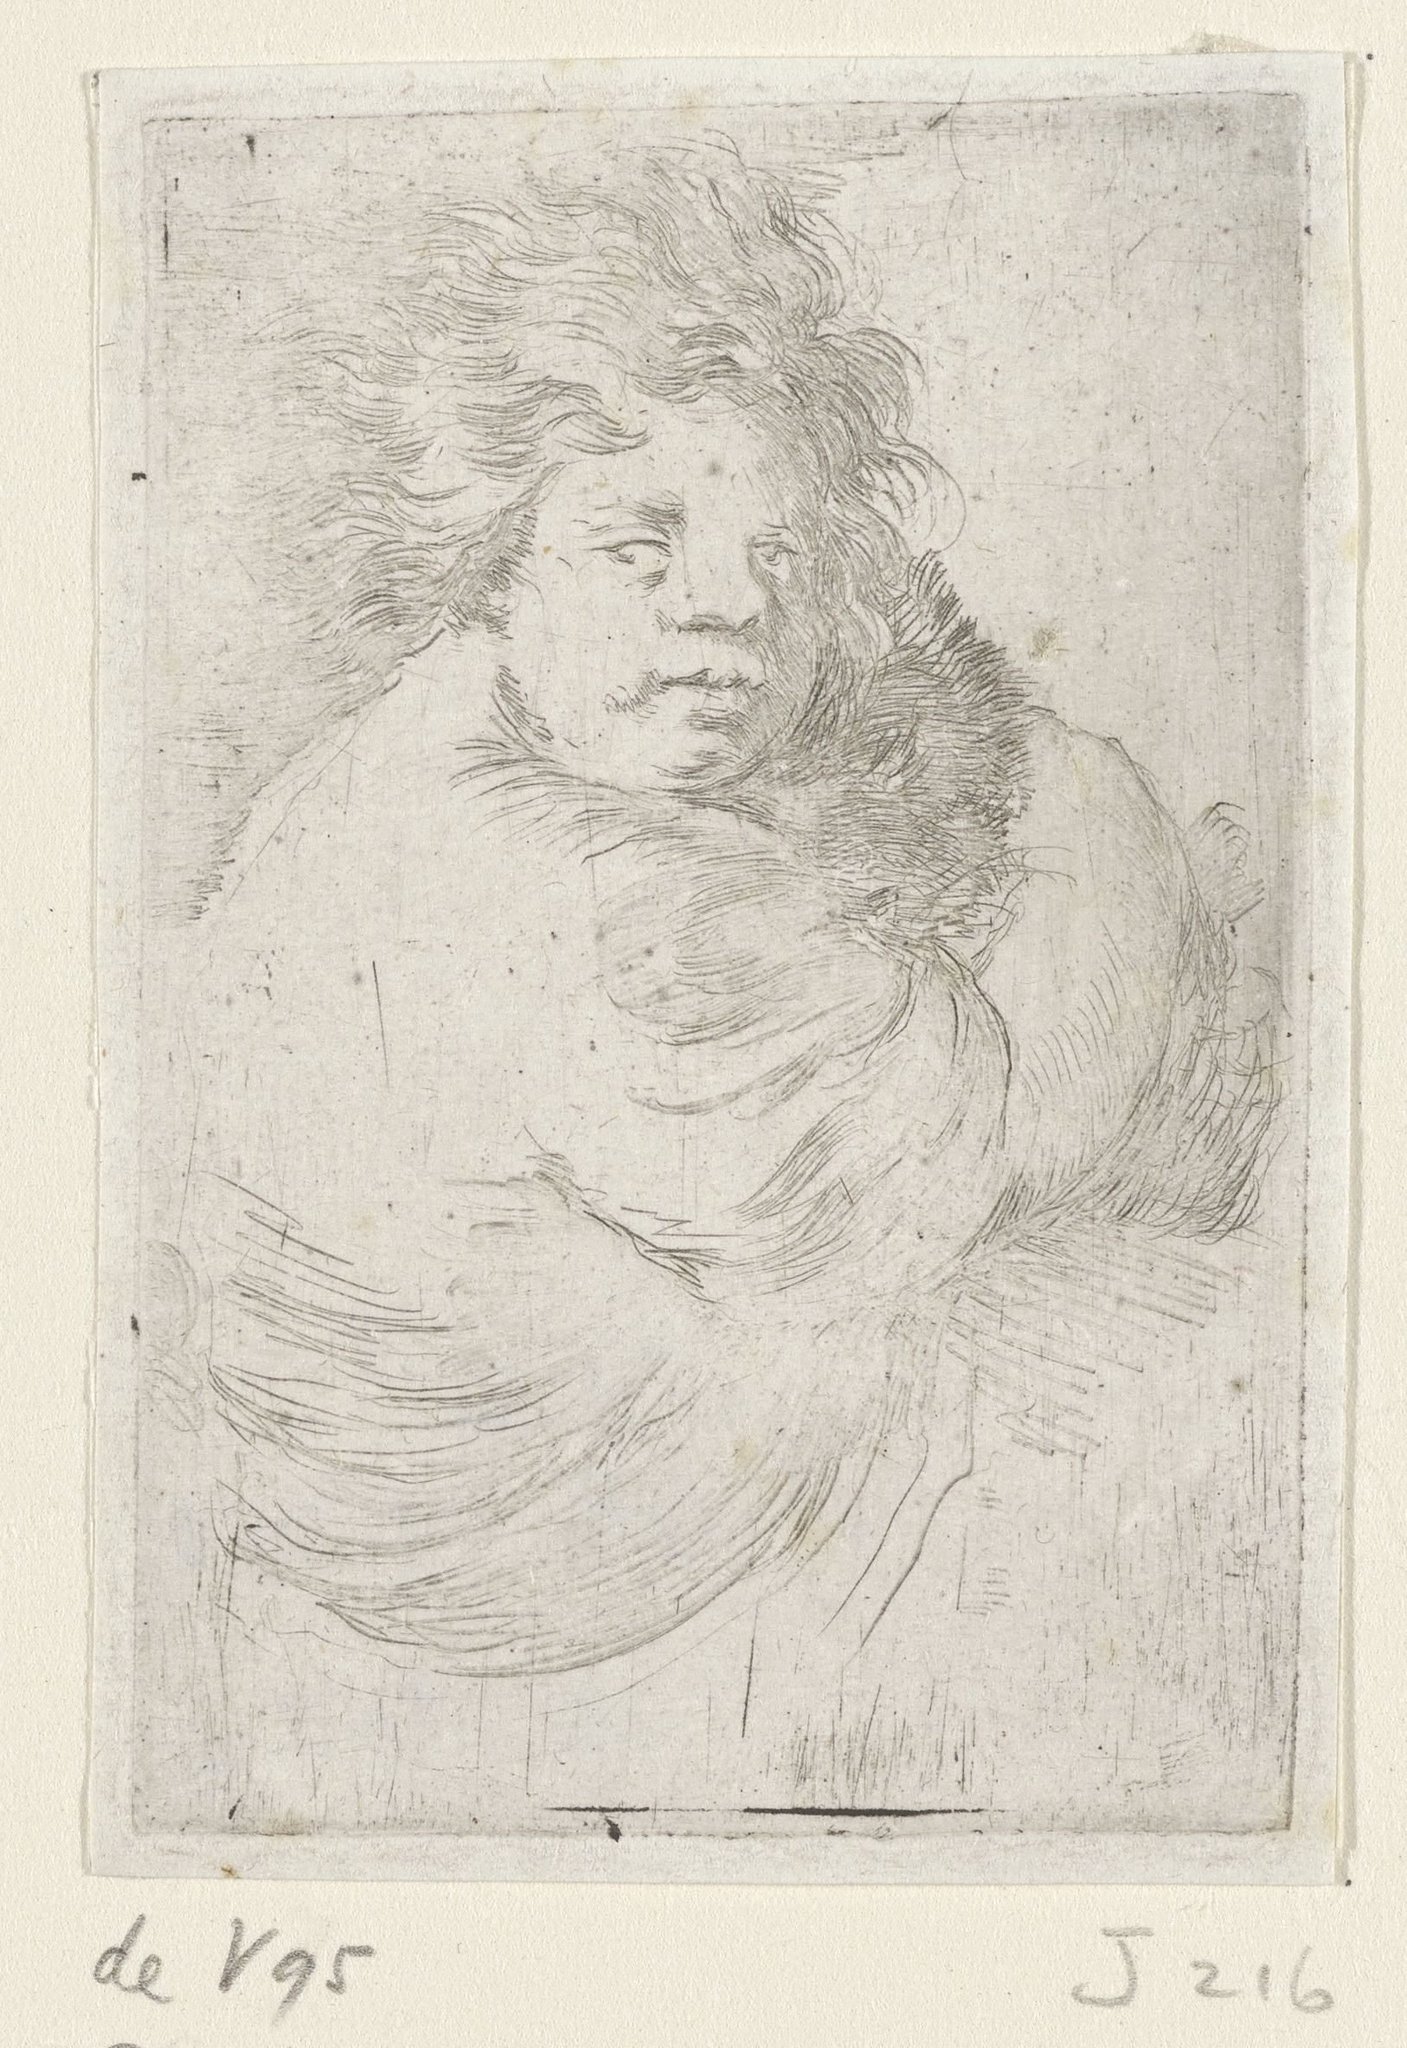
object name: print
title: Kind met een kat in zijn armen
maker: stefano della bella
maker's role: draughtsman, print maker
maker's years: 1610-1664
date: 1620-1664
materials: paper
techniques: etching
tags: cat, child, child playing with animals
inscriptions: collector's mark: Lugt 240